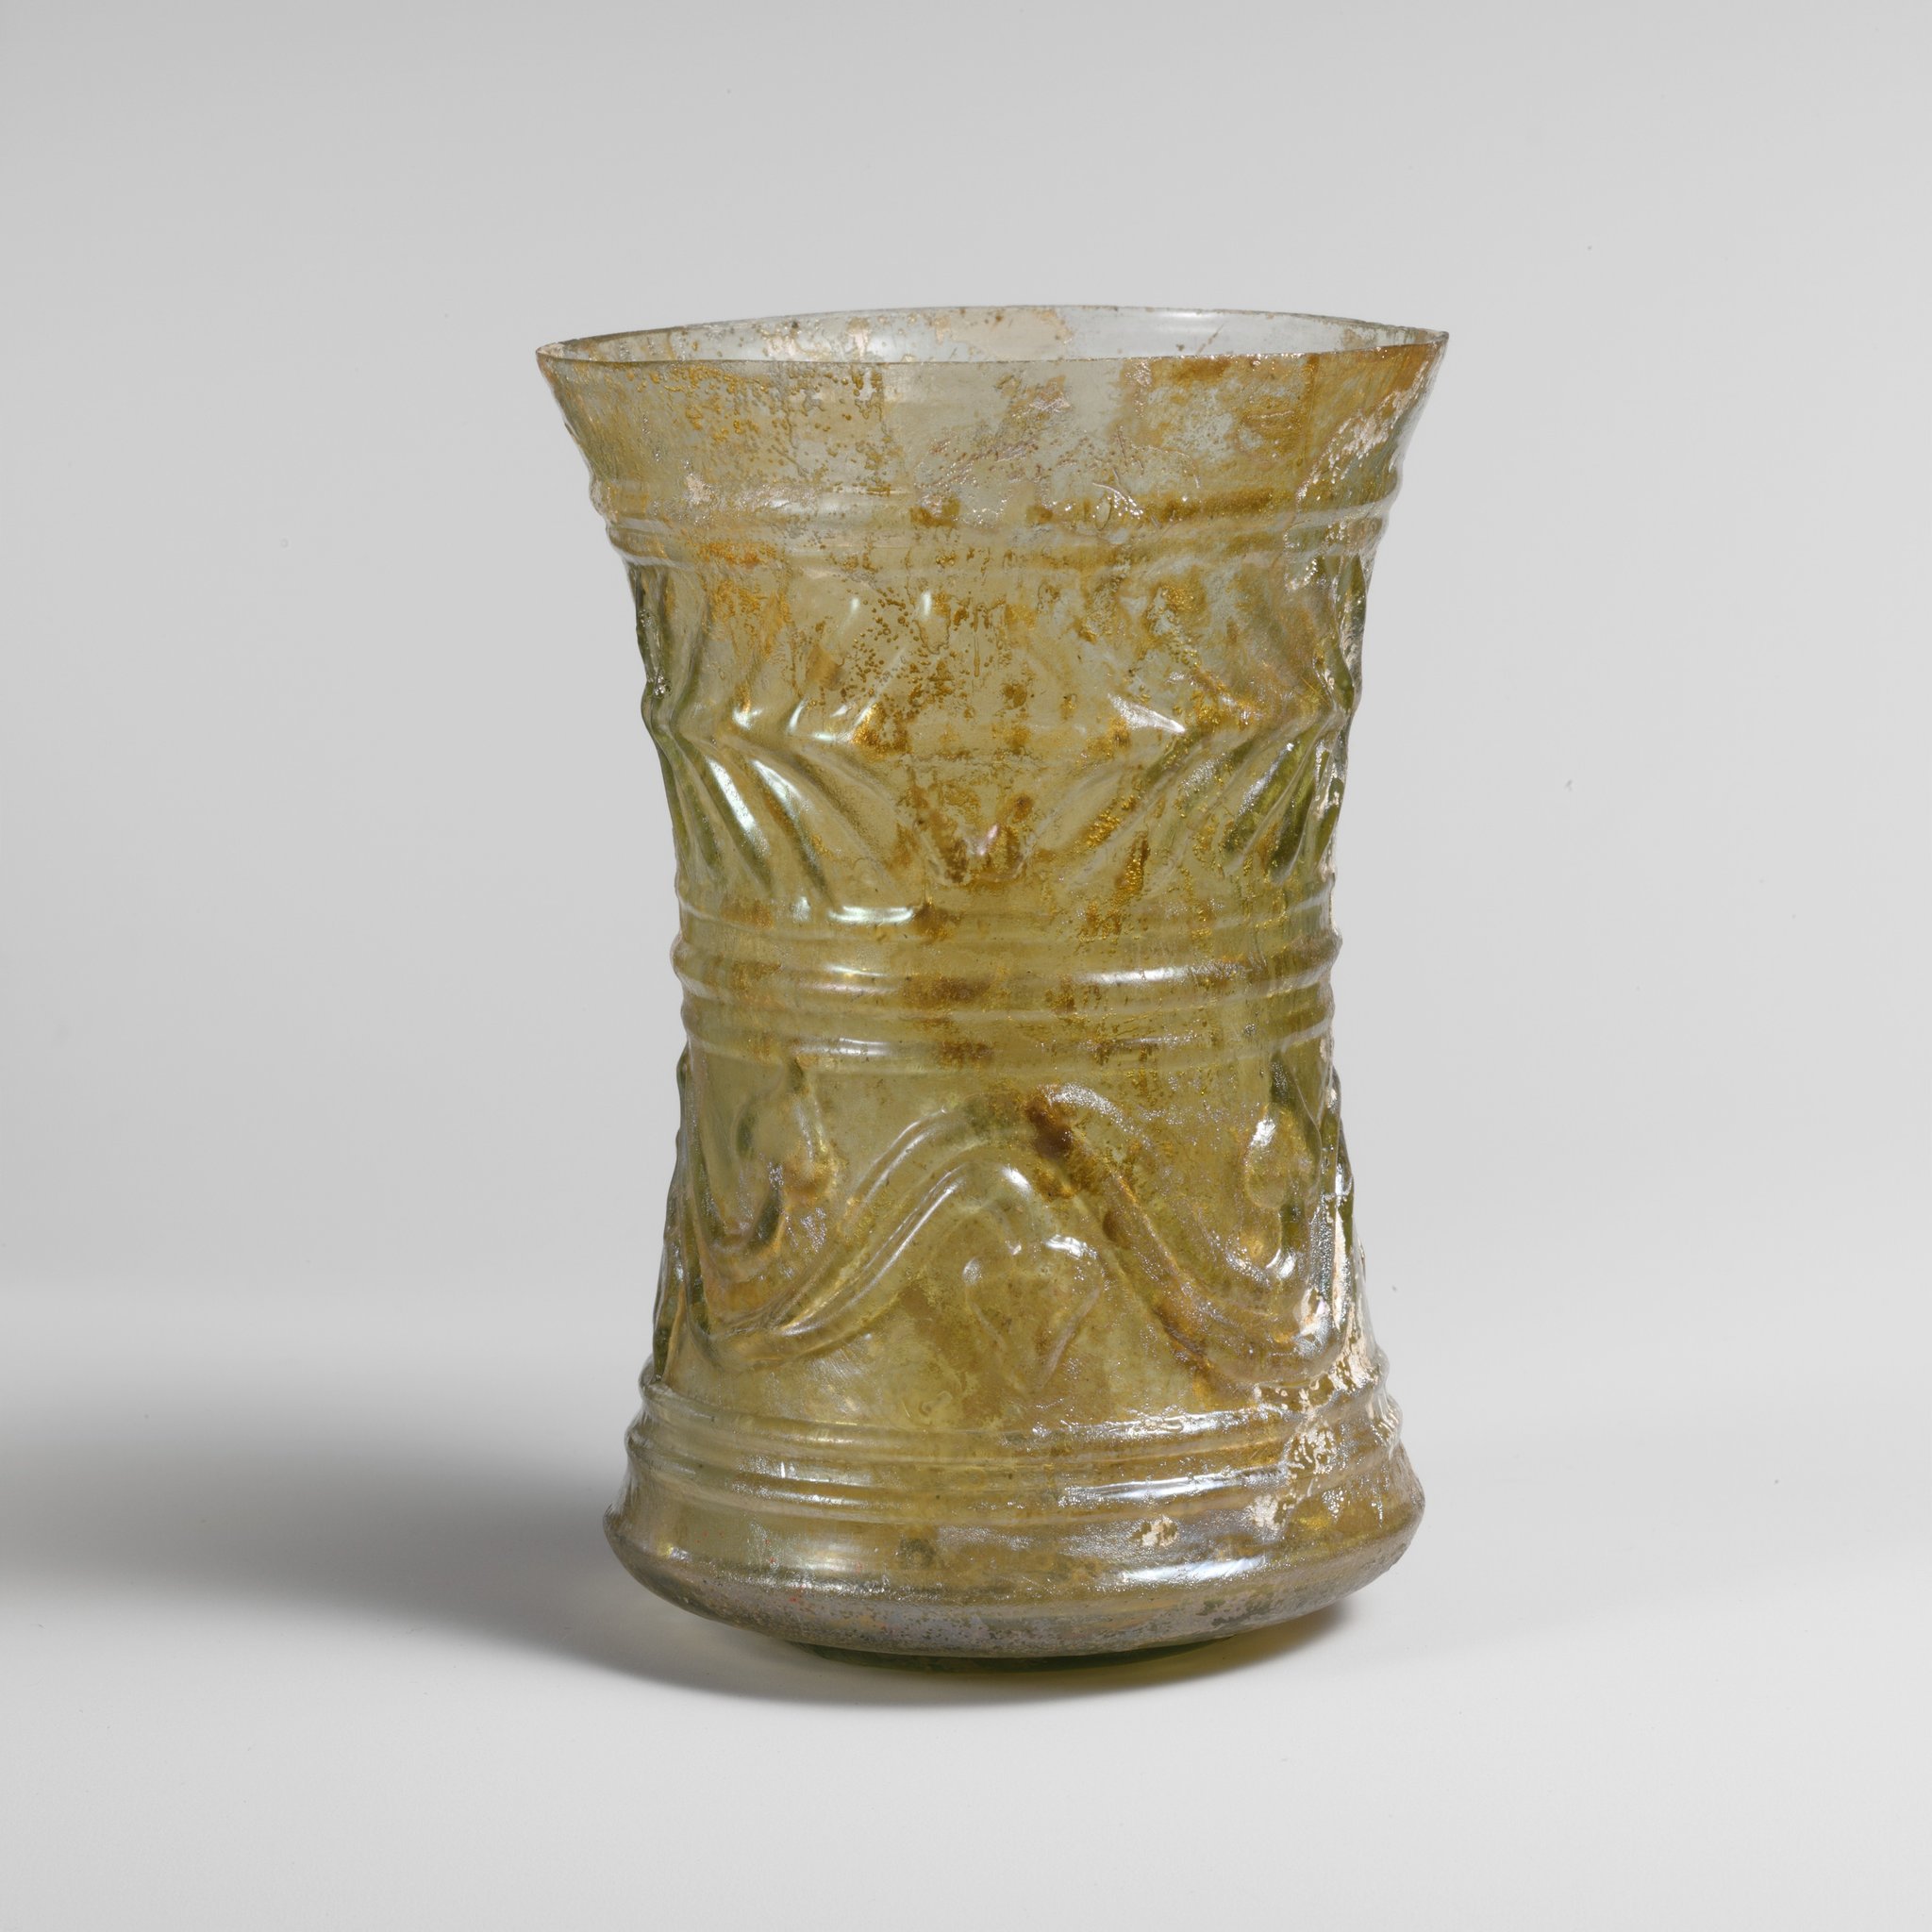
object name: beaker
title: Glass beaker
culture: roman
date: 1-100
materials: glass